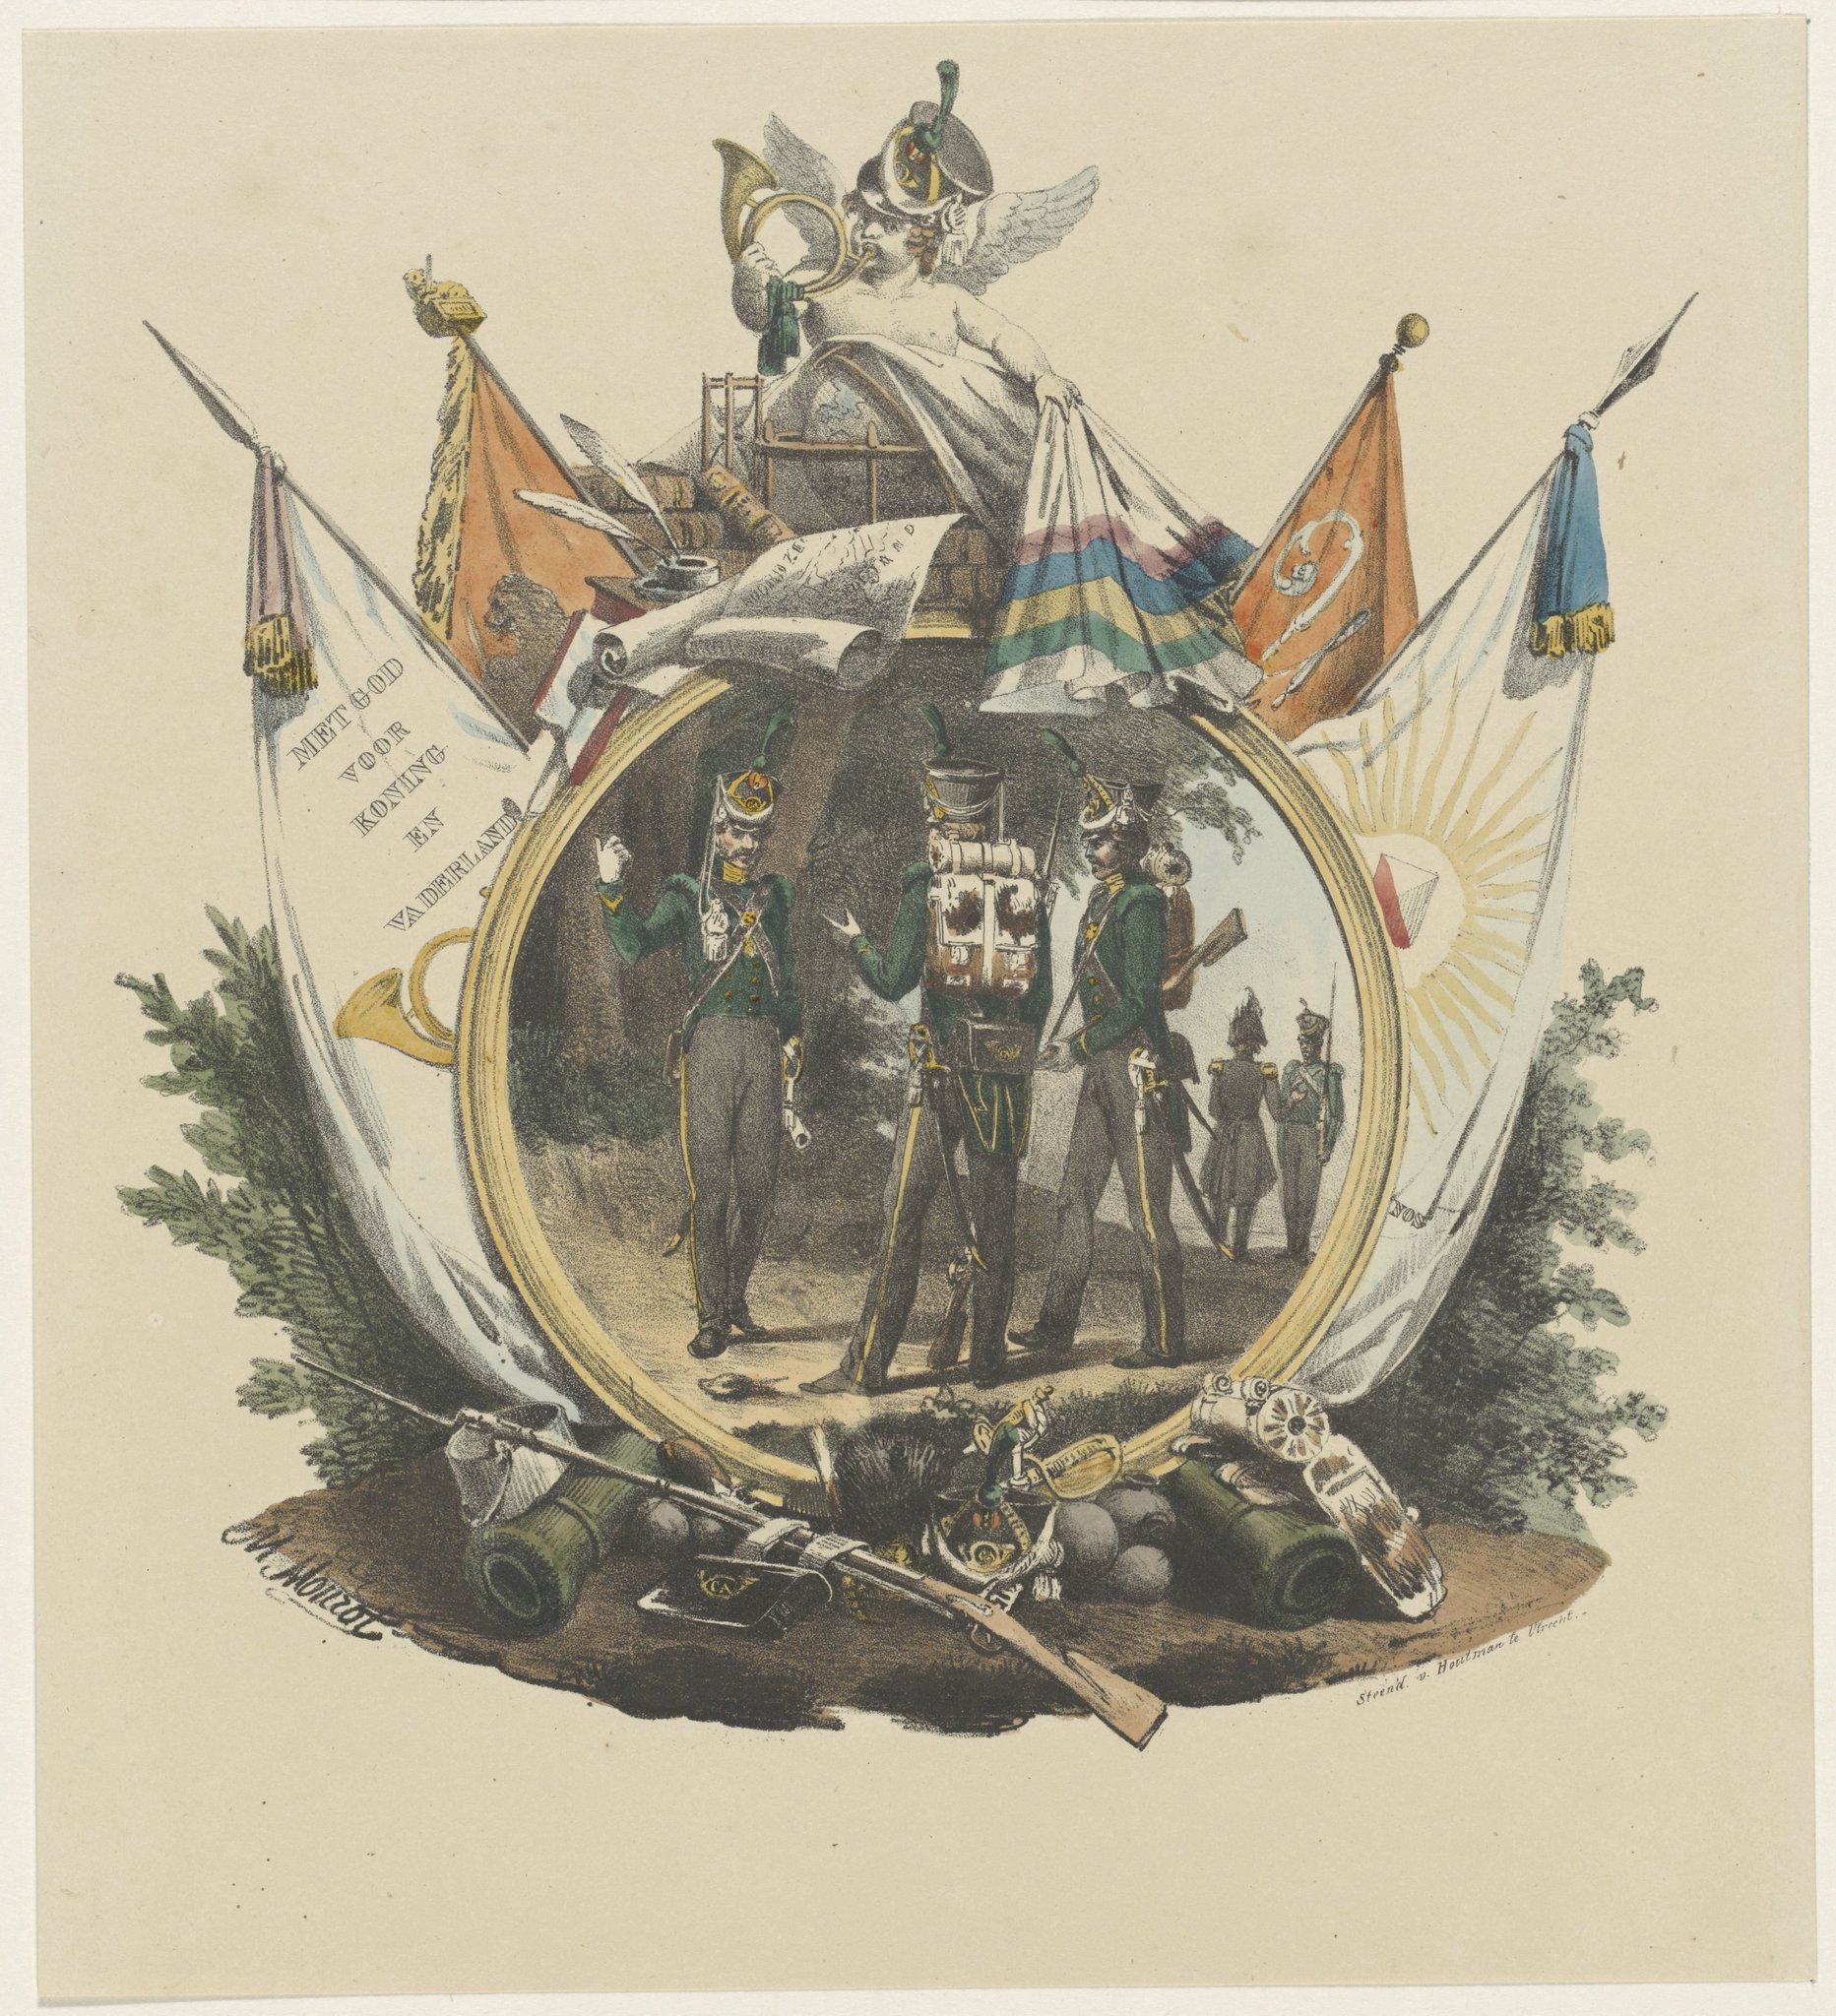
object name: print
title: Medaillon met Vrijwillige Jagers der Utrechtse Hogeschool, 1830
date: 1830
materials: paper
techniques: hand coloring, lithograph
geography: utrecht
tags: (military) uniforms, clothes, costume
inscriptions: collector's mark: Lugt 2228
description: Allegorisch medaillon met een voorstelling van enkele Vrijwillige Jagers der Utrechtse Hogeschool, 1830. Op de grond voor het medaillon liggen wapens en delen van de wapenrusting. Aan weerszijden vaandels, rechts een vaandel met het stadswapen van Utrecht. Bovenaan attributen van de universitaire studie: boeken, pen en papier, met een putto met helm die op een hoorn blaast. Zie ook de pendant.